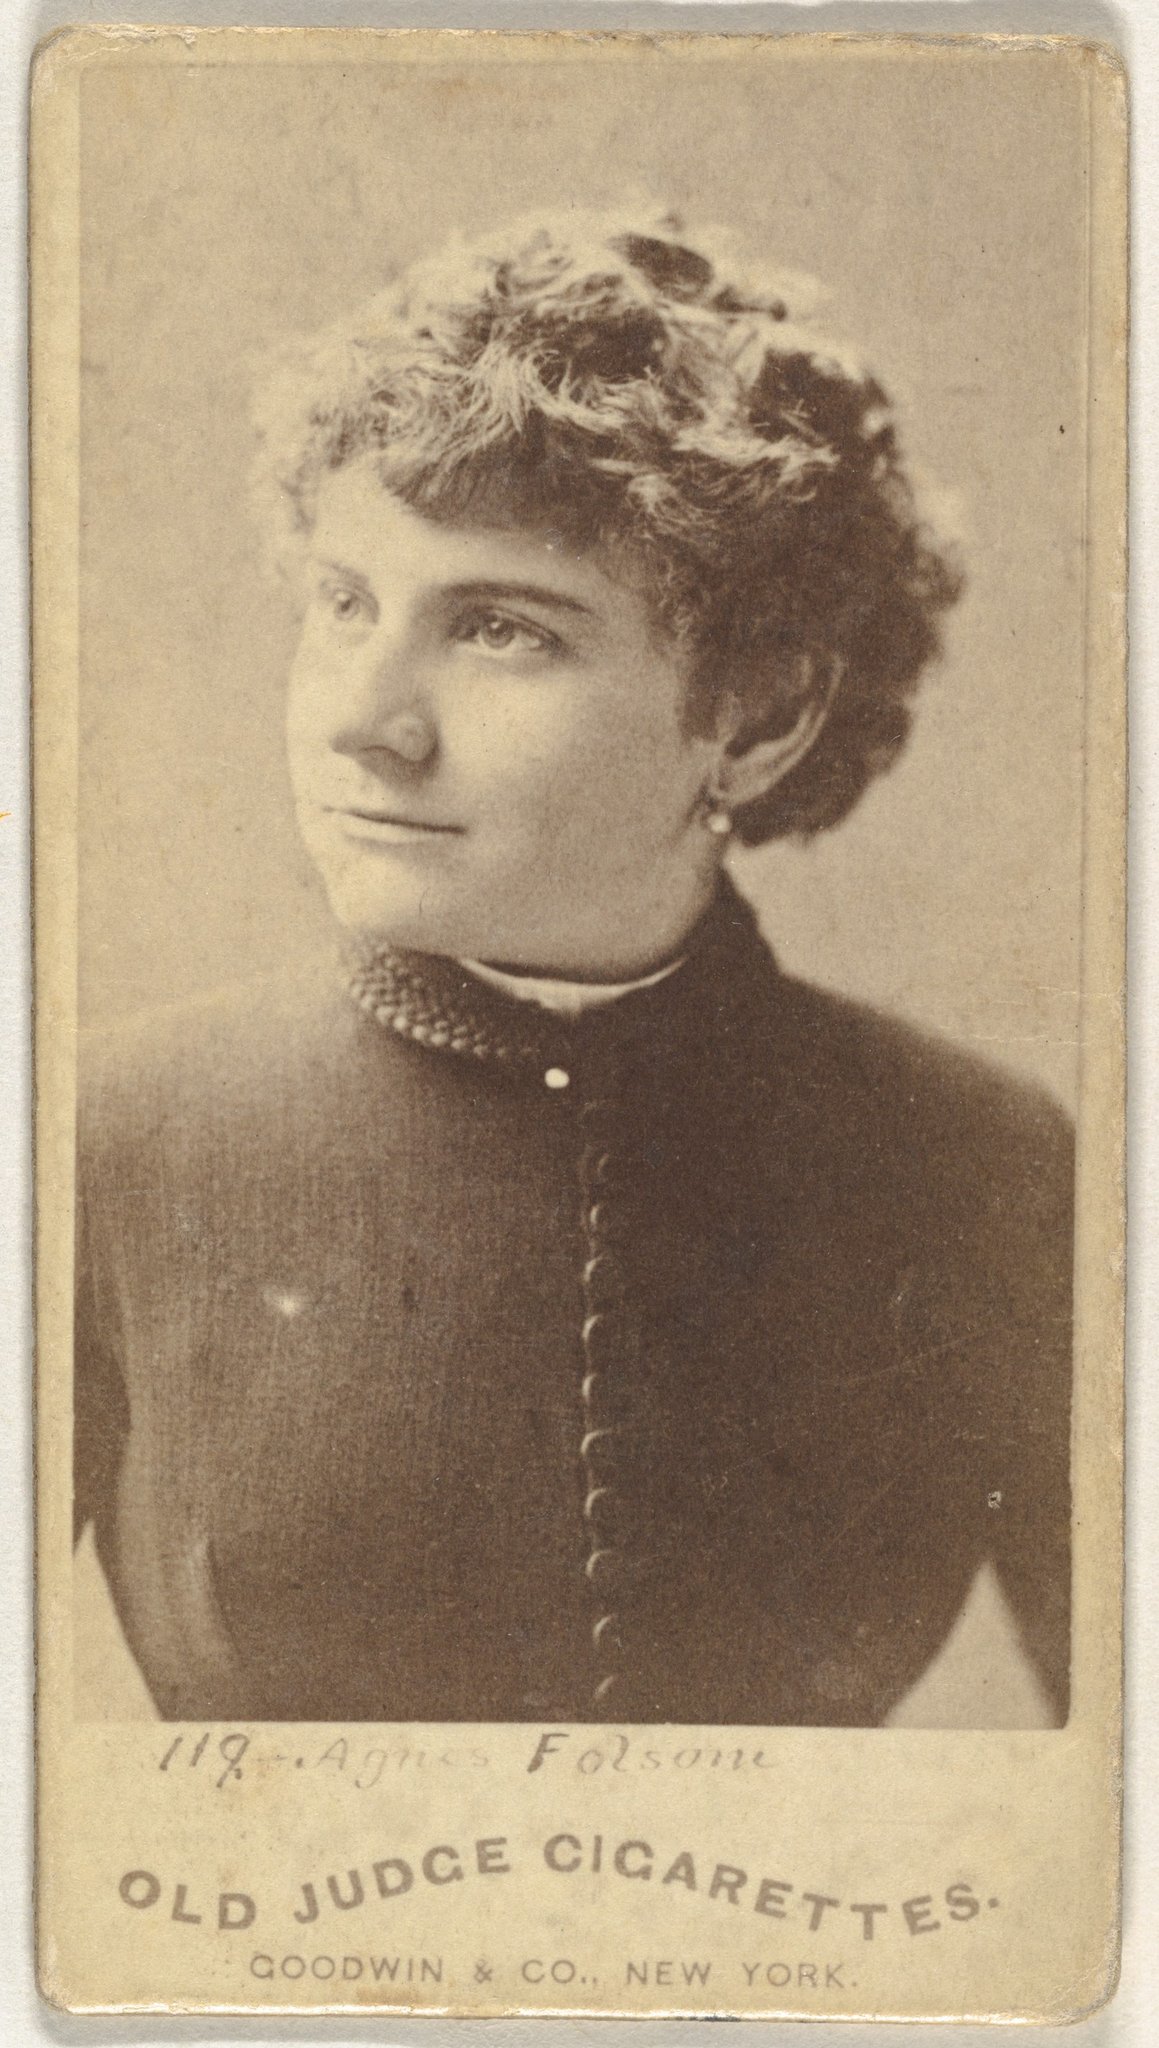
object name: photograph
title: Agnes Folsom, from the Actors and Actresses series (N171) for Old Judge Cigarettes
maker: goodwin & company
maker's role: publisher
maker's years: 1850-1950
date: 1886-1890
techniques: albumen silver print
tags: portraits,women,actresses